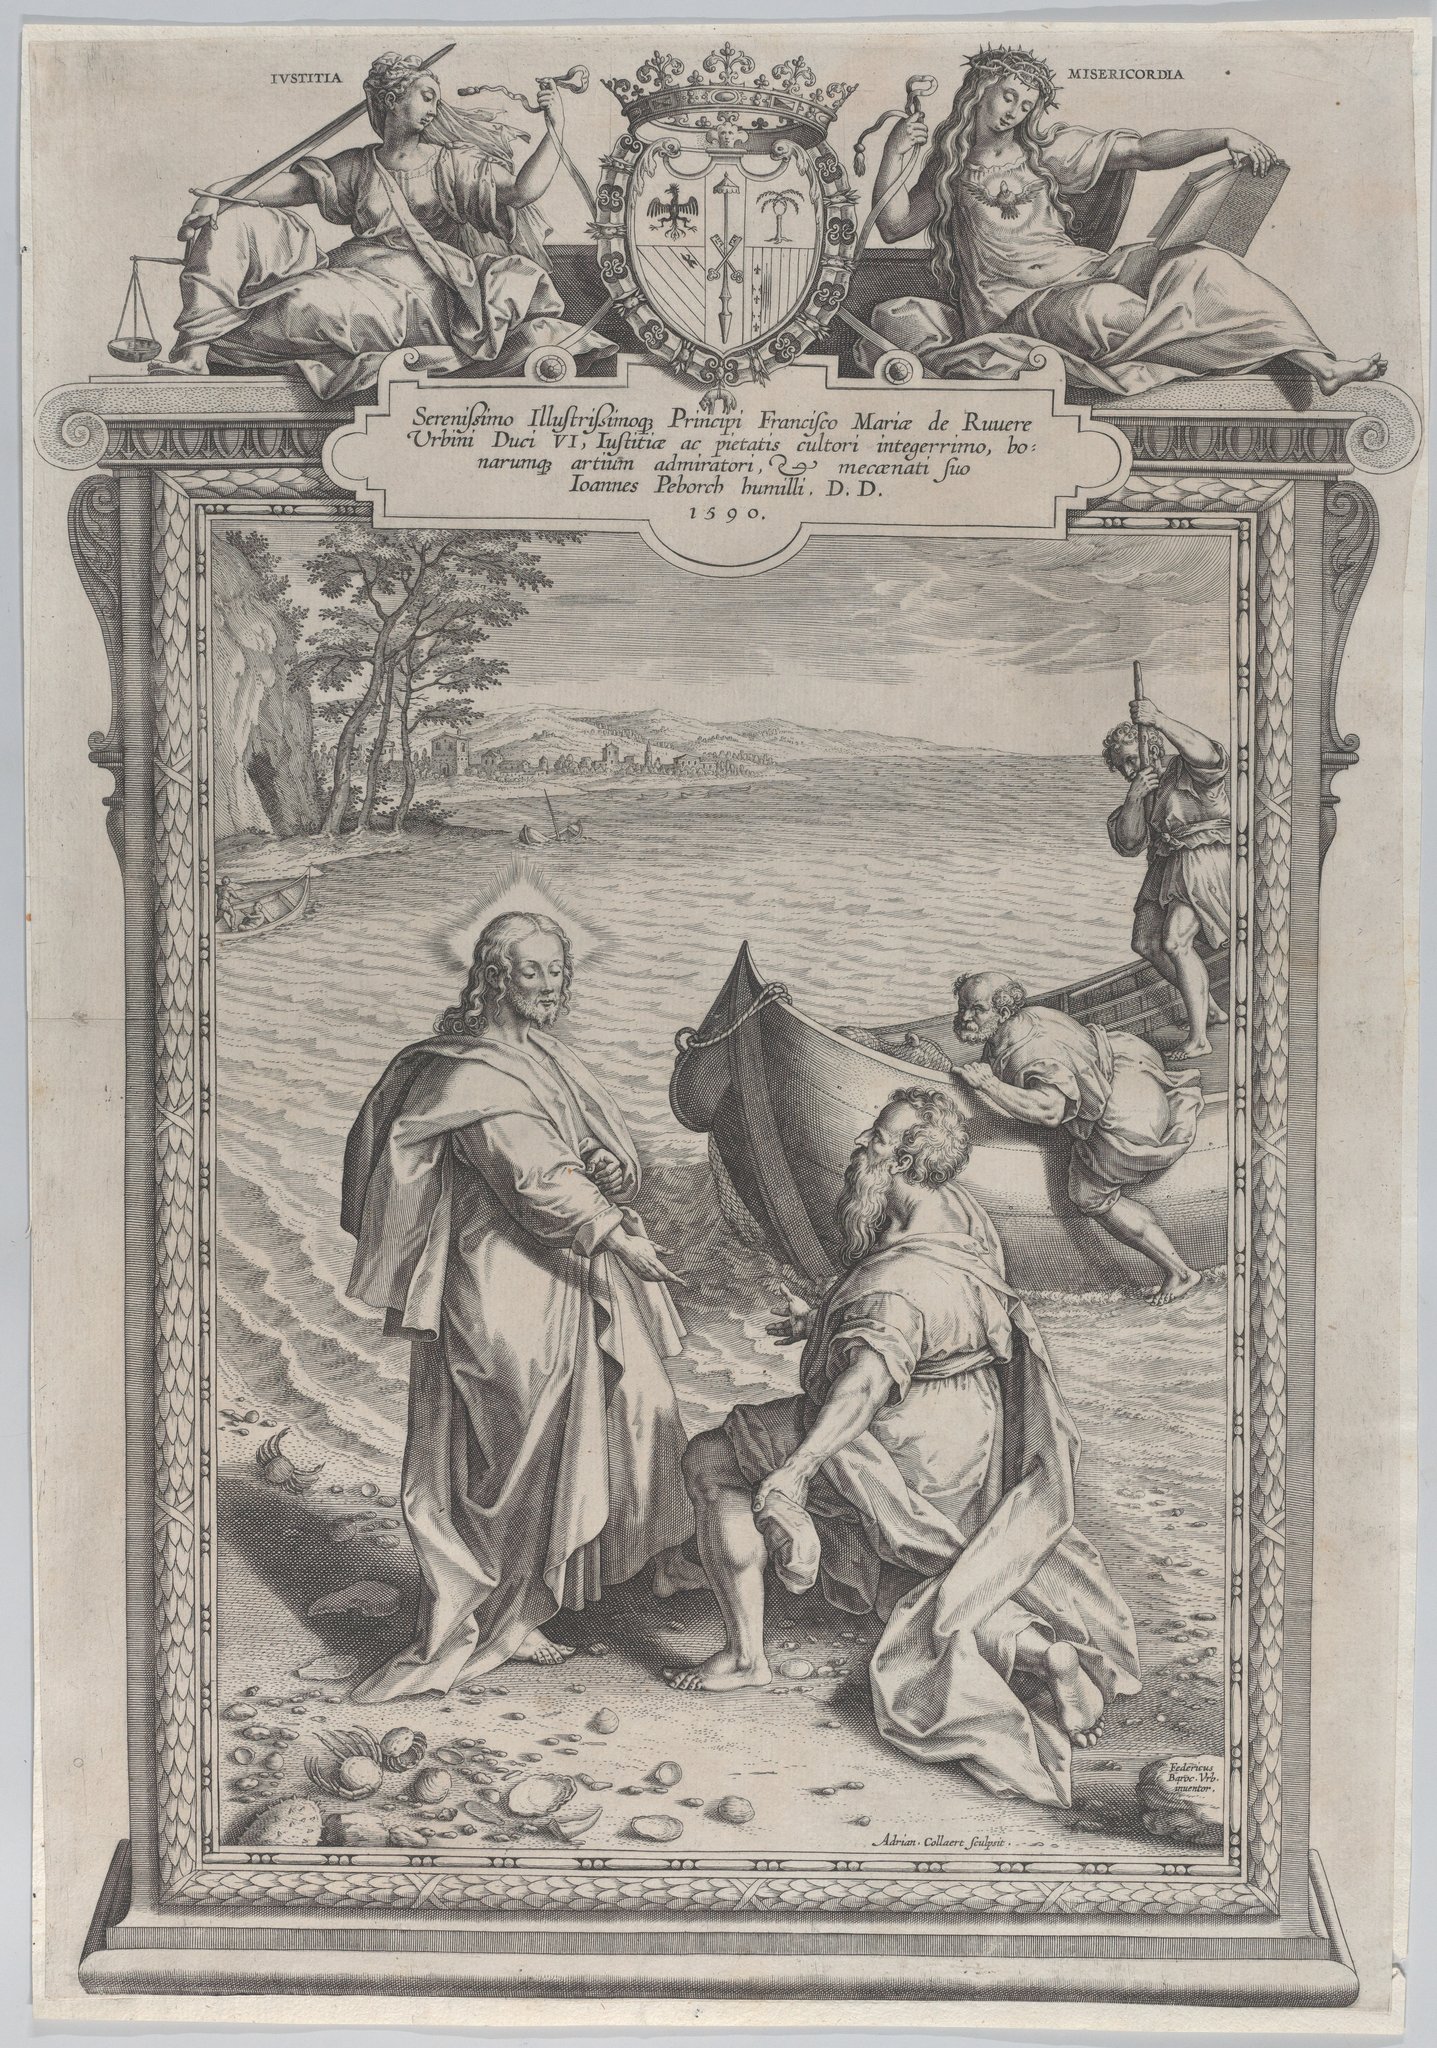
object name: print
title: Christ calling Saint Andrew, who kneels before him on a beach, and Saint Peter, who climbs out of a boat at right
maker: adriaen collaert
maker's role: artist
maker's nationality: netherlandish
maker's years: 1560-1618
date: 1590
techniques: engraving